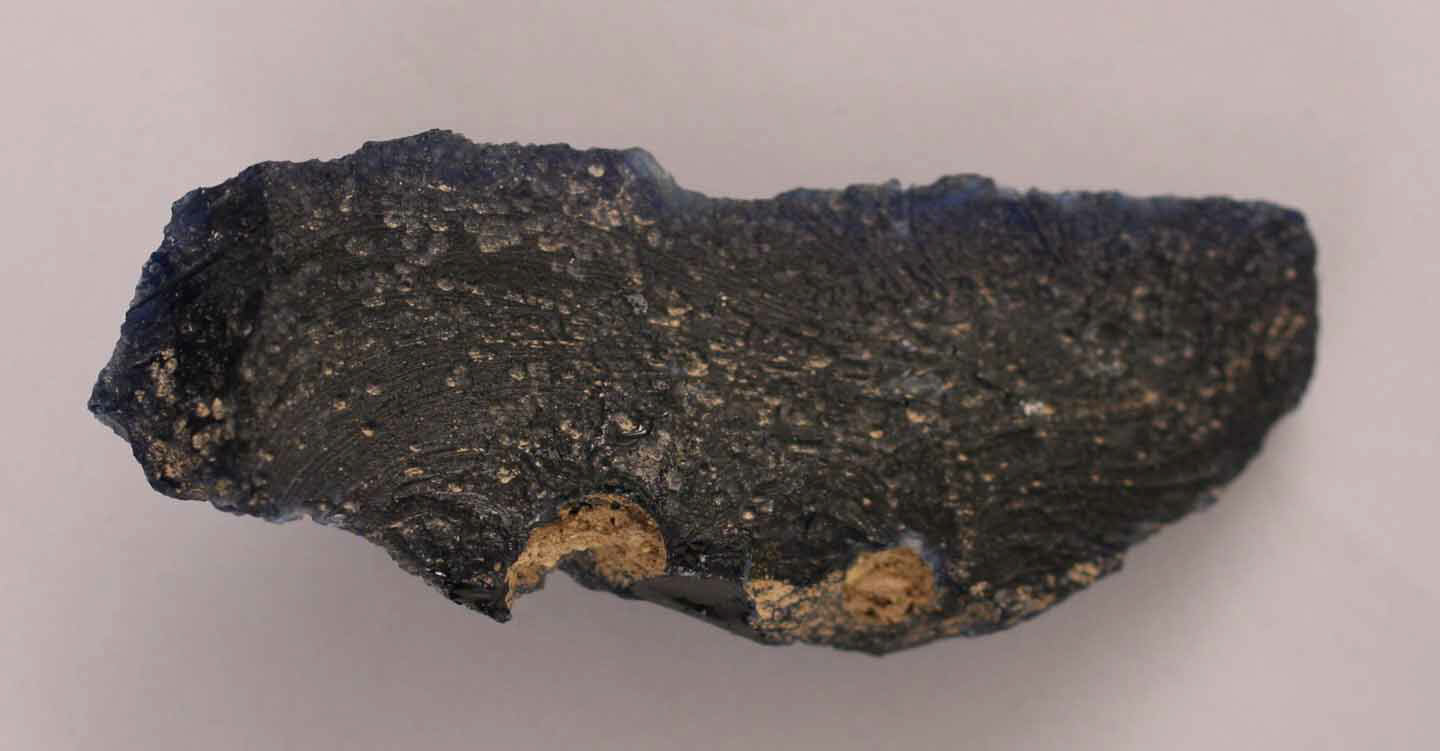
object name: fragment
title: Ceramic Fragment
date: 801-900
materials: glass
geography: iraq